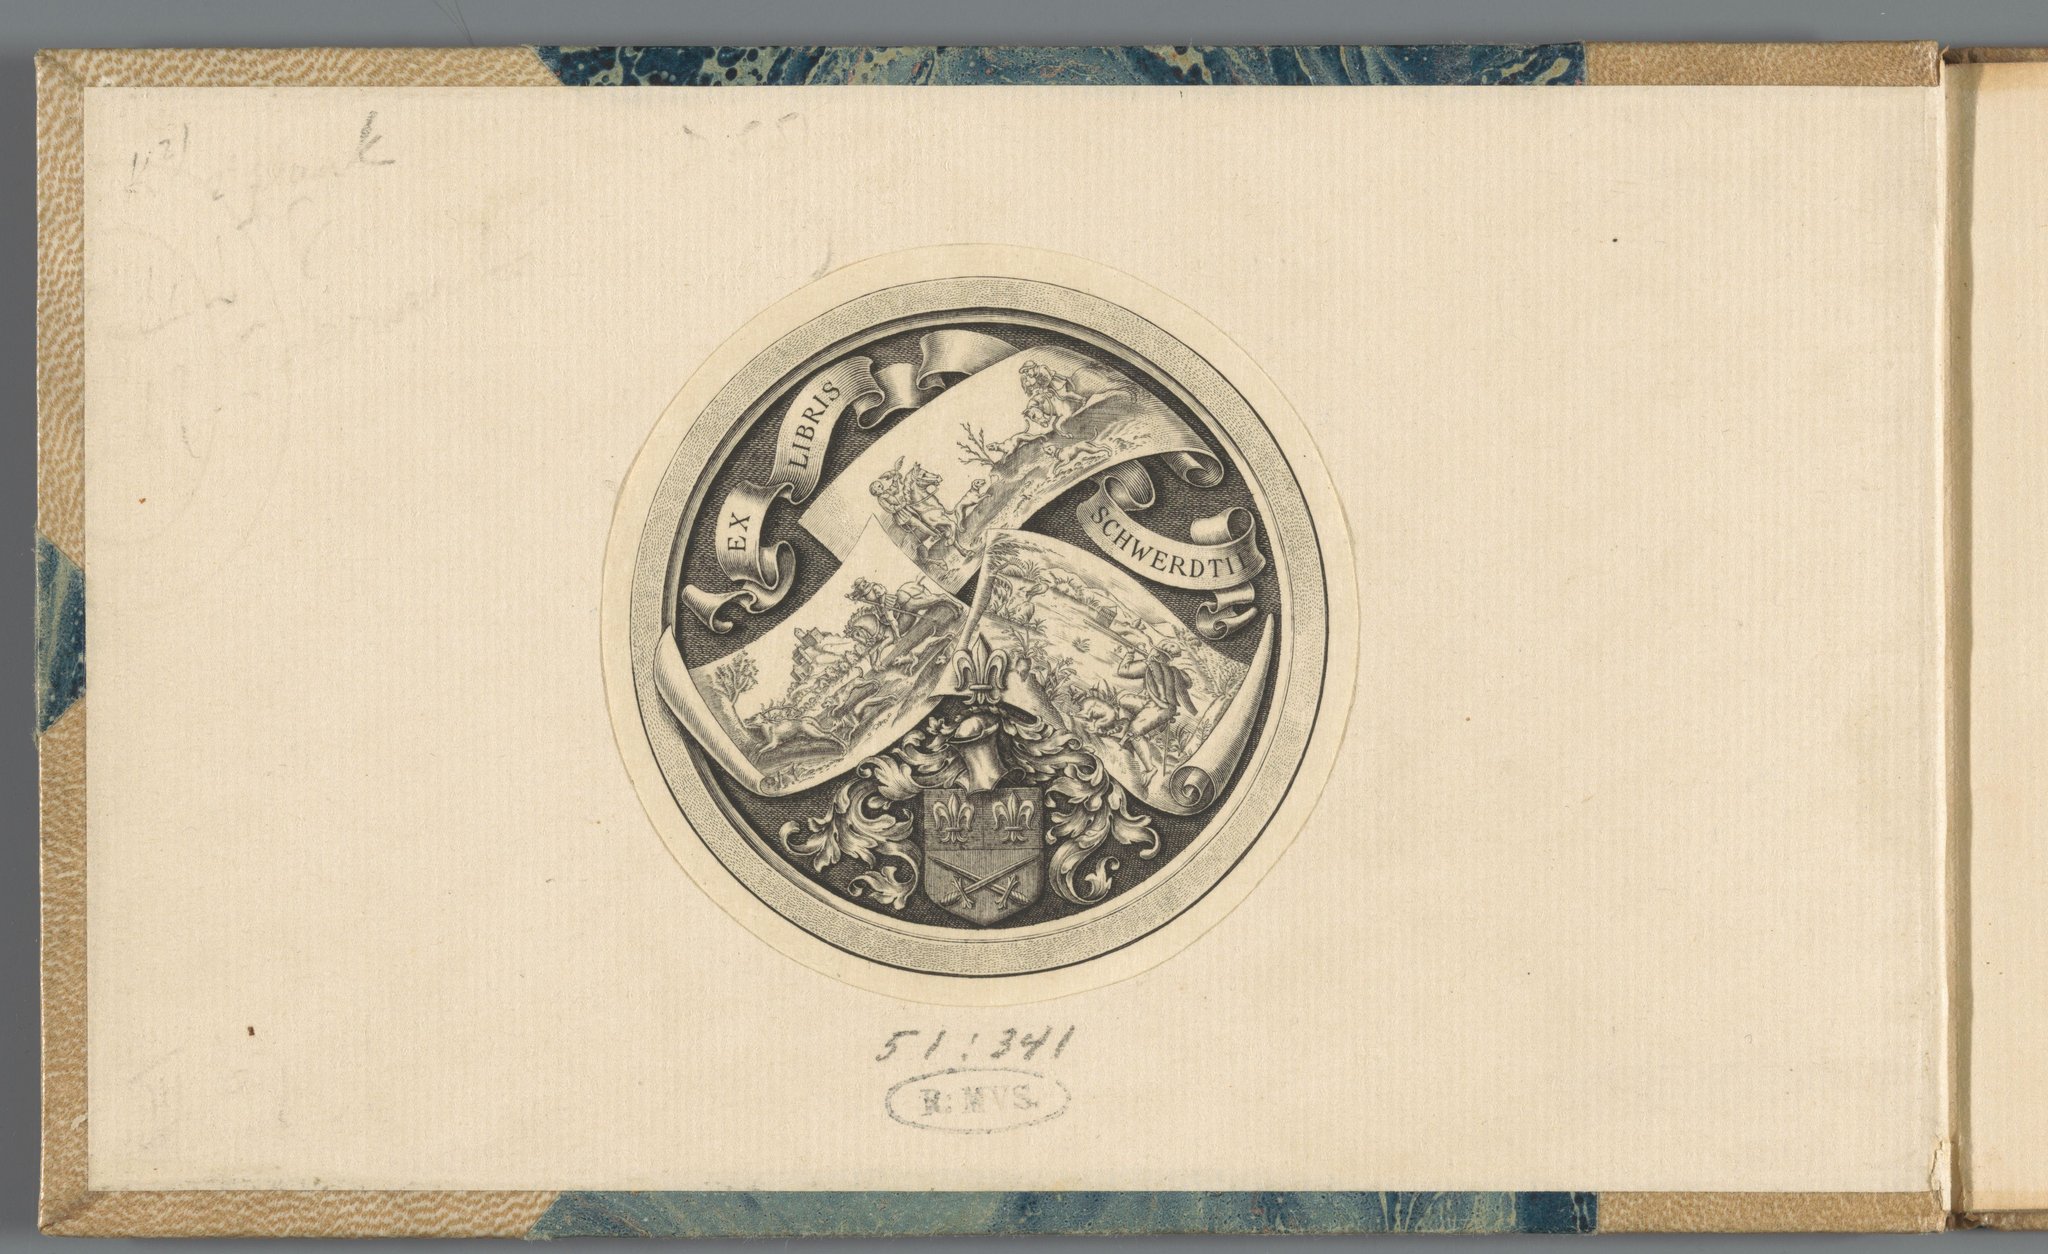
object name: bookplate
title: Ex libris van Carl Franz Georg Richard Schwerdt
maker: Anonymous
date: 1882-1939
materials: paper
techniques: engraving, etching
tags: hunting, chase, armorial bearing, heraldry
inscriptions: collector's mark: Lugt 2228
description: Medaillon met drie voorstellingen van prenten met jachtscènes. Onderaan het wapenschild van Carl Franz Georg Richard Schwerdt. Bovenaan een banderol met tekst: Ex Libris Schwerdtii. Deze prent maakt deel uit van een album.